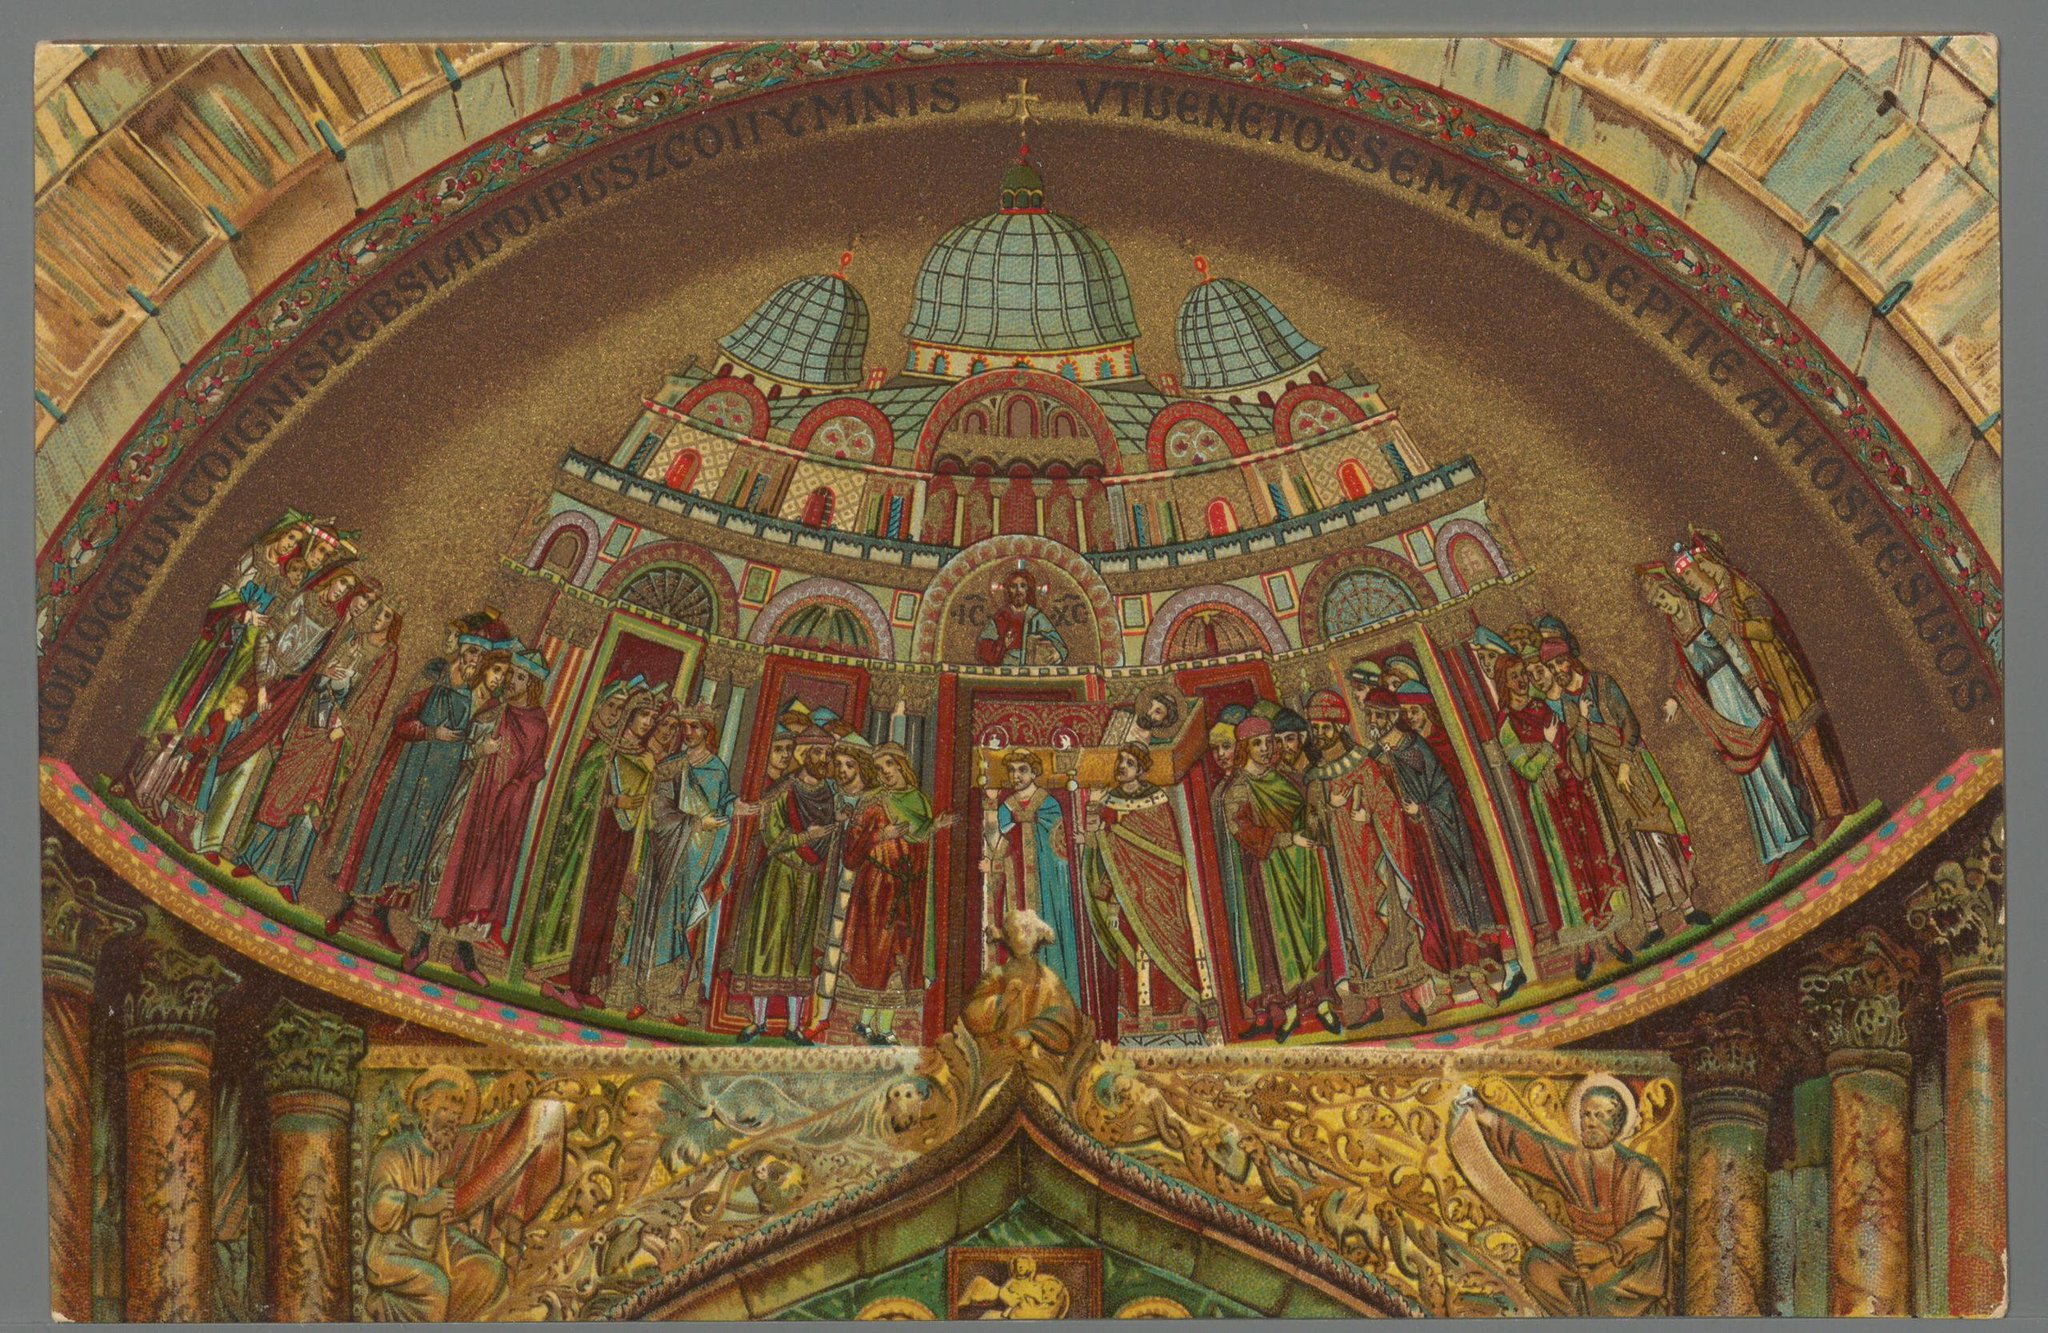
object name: reproduction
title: Antico mosaico (Facciata). Il corpo di S. Marco portato processionalmente in chiesa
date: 1906-1920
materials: cardboard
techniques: lithograph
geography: milan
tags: parts of church interior: vault, the monumental arts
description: Oorspronkelijke prent uit: La Basilica di San Marco in Venezia. Venetië: Ferdinando Ongania, 1881-1884. De oorspronkelijke prenten uit dit werk zijn gesigneerd.